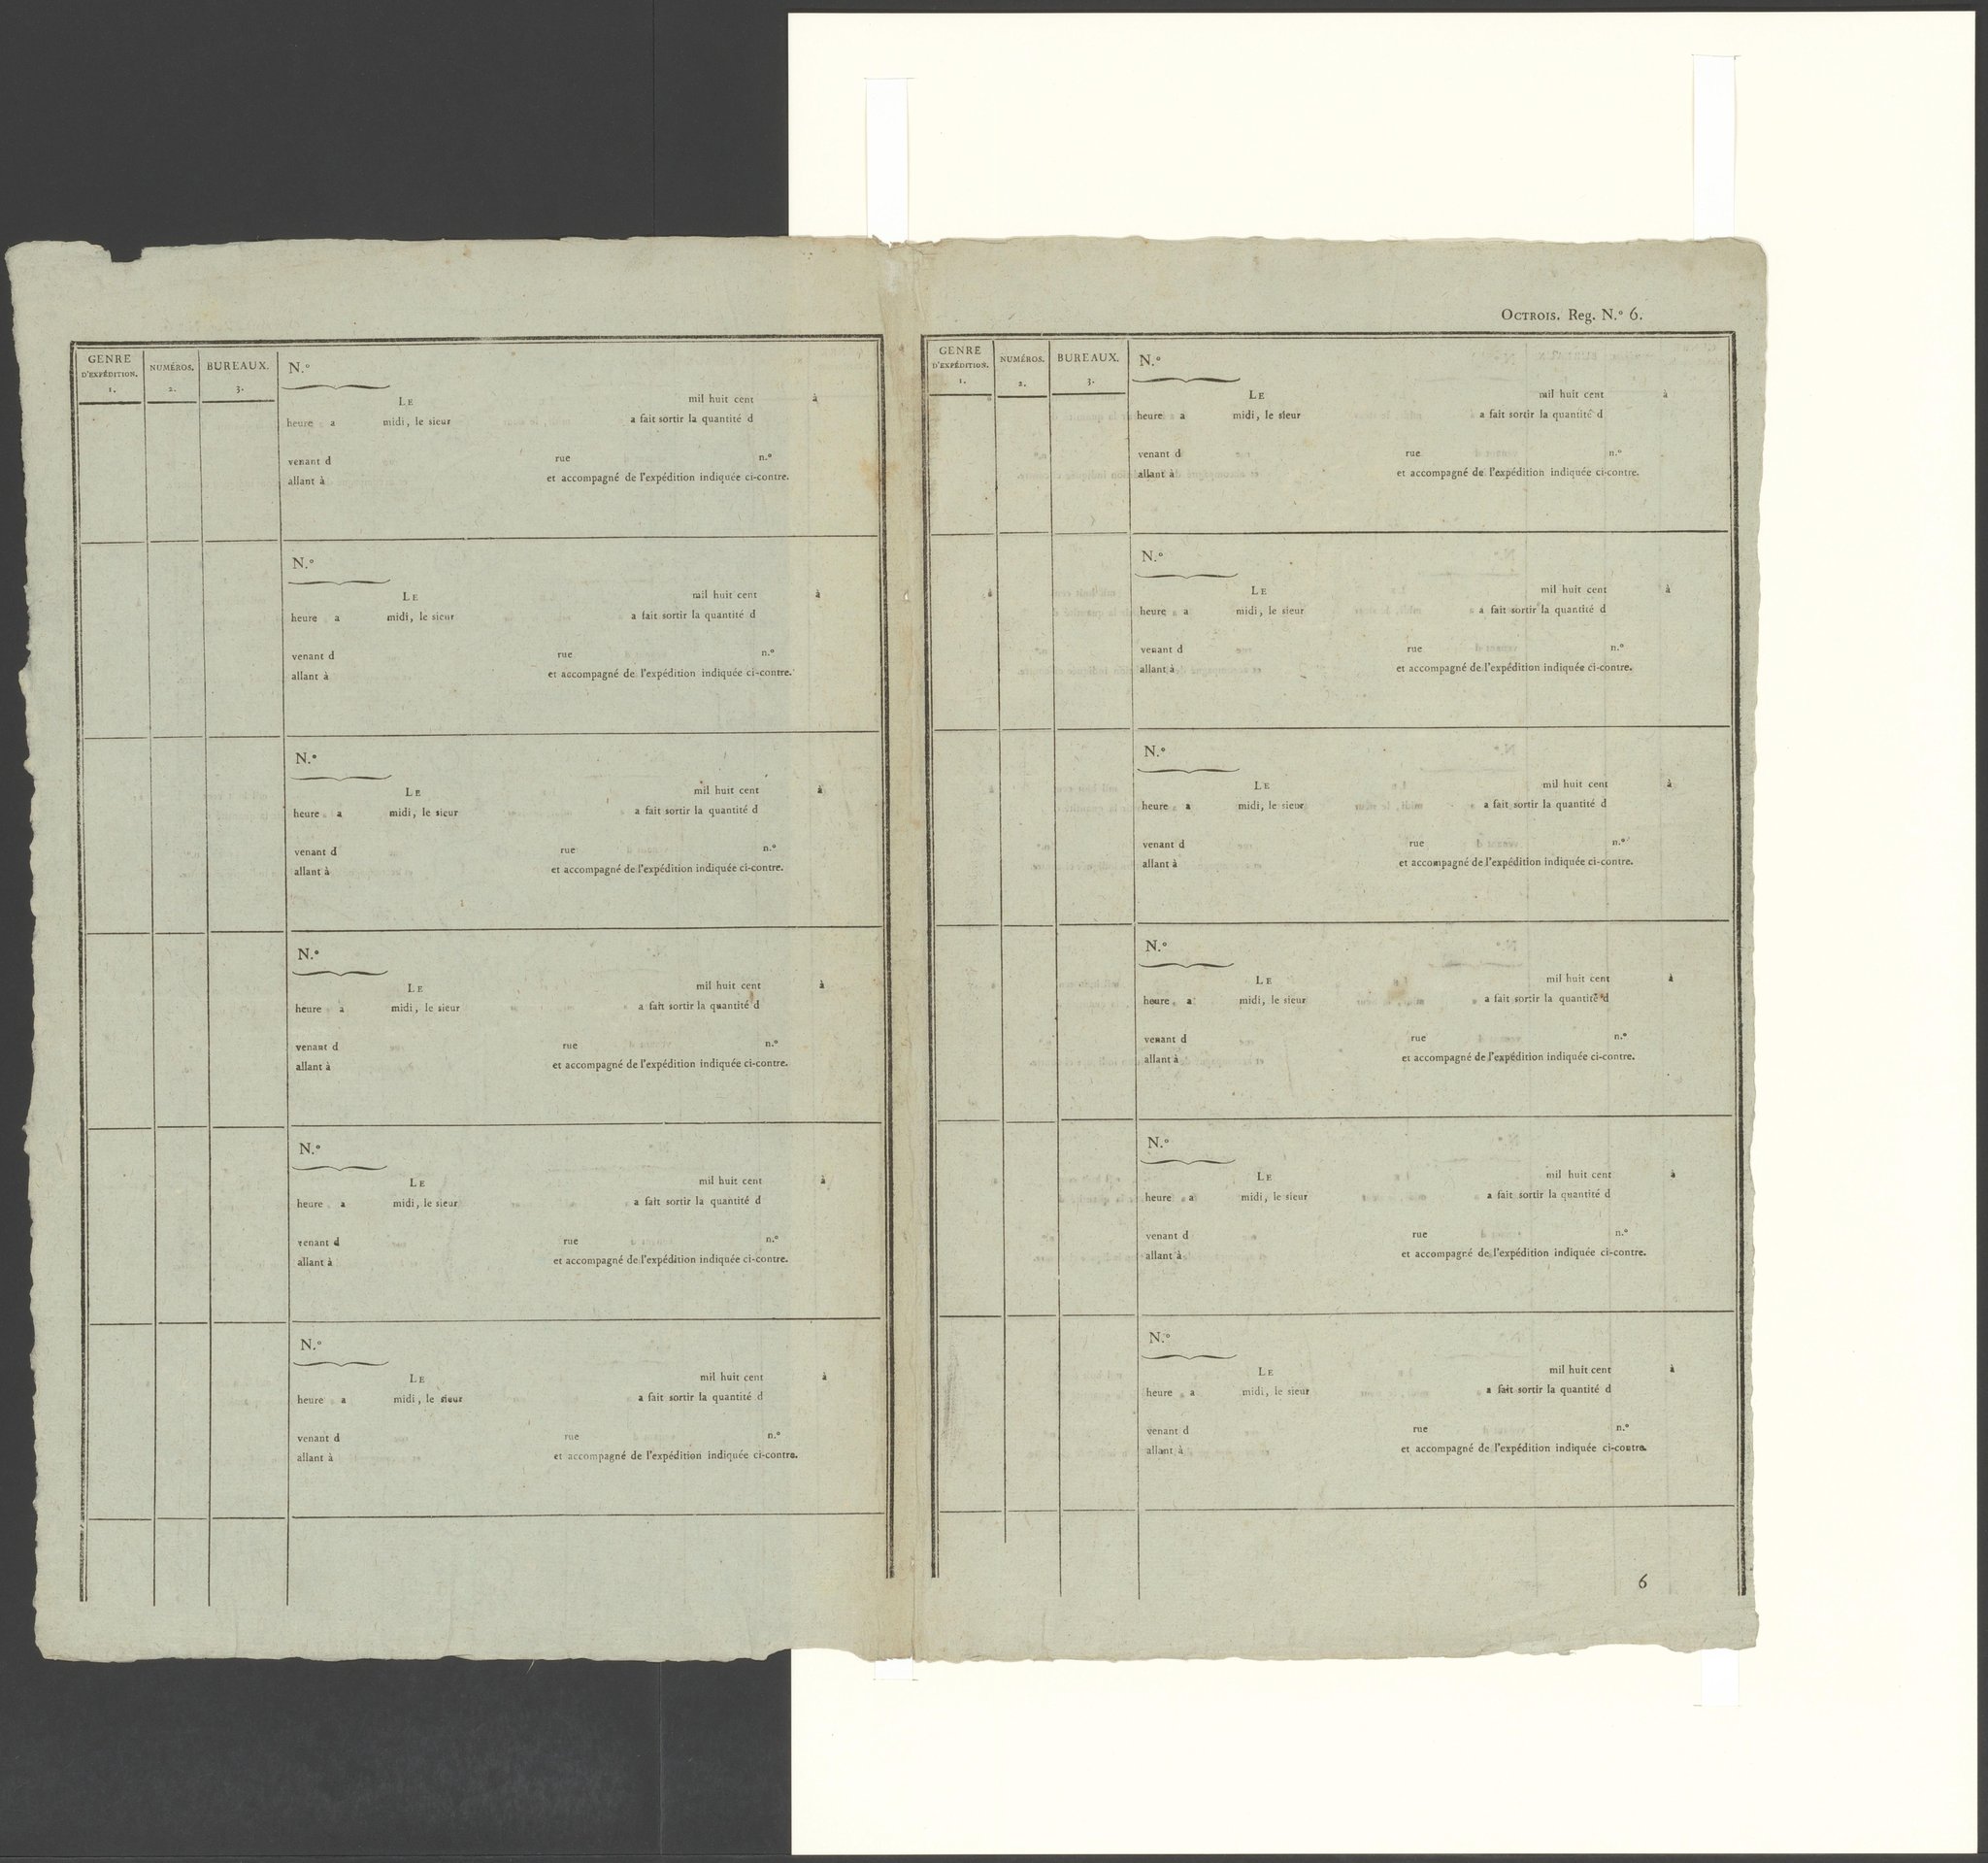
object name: text sheet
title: Onversneden blad met loterijbriefjes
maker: Anonymous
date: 1800-1890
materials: paper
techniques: letterpress printing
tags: raffle, lottery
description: Onversneden blad met ongenummerde loterijbriefjes. Blad bedrukt op beide zijden met tekst in het Frans. Bovenaan gemerkt: 'Octrois. Reg. No. 6:'. Onderwerpsrubrieken binnen de Atlas Zeden en Gewoonten: Spel en Vermaak; Loterij.